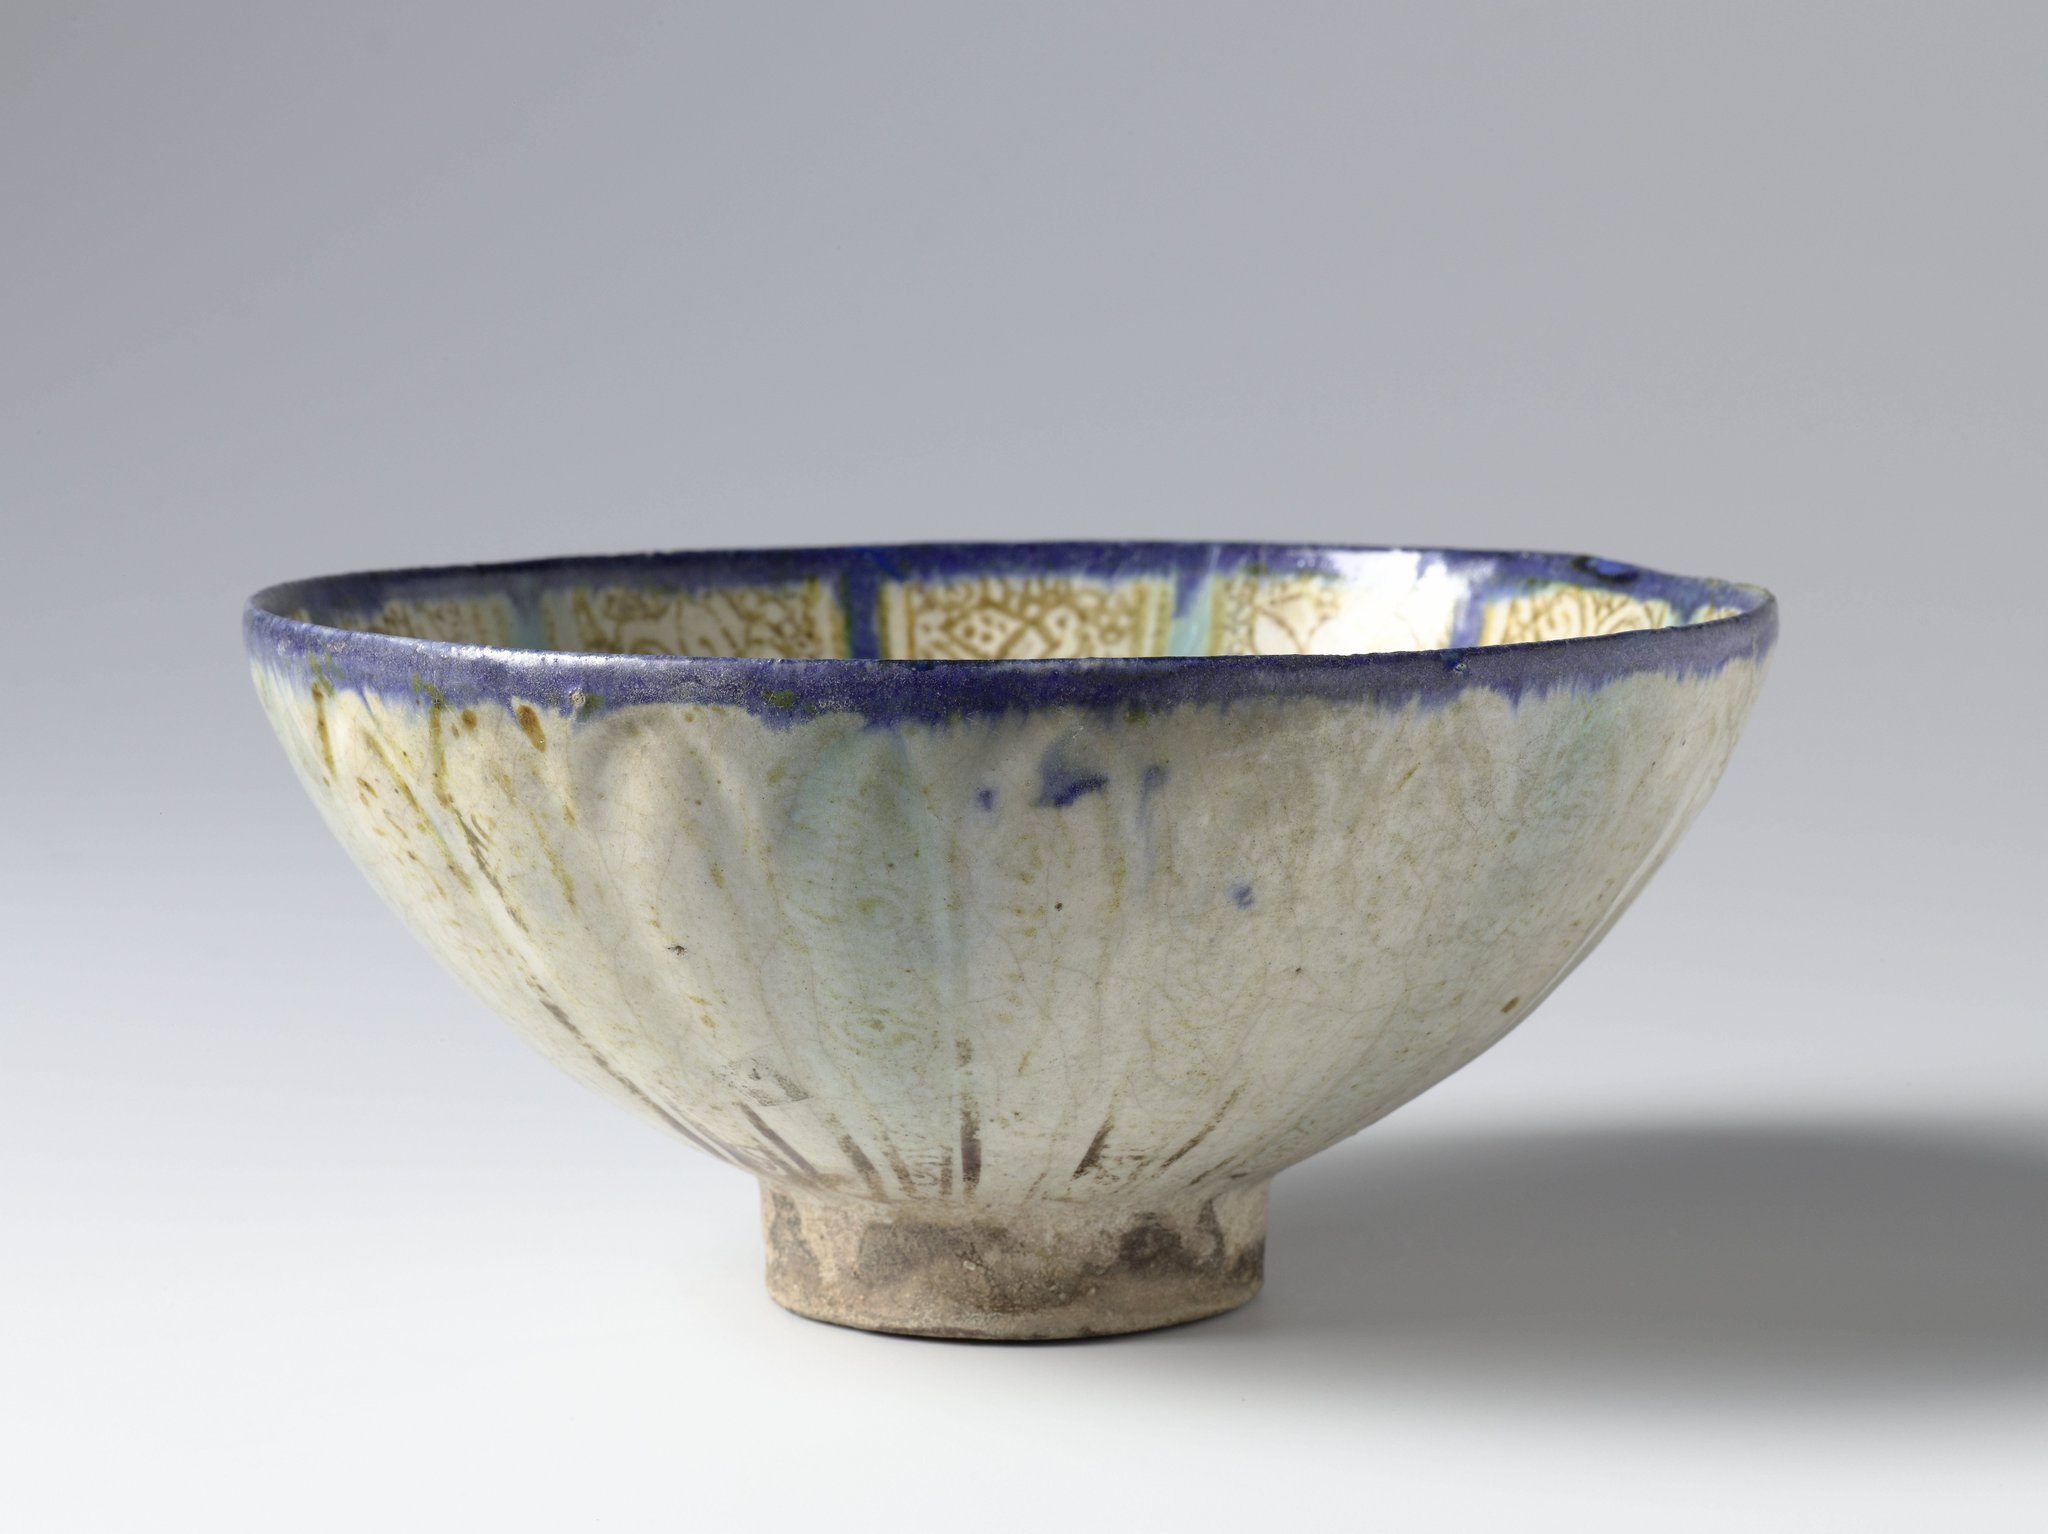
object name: bowl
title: Bowl with twelve panels with floral scrolls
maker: Anonymous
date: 1200-1299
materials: cobalt, earthenware, glaze, luster, paint, quartz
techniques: firing, turning, vitrification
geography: kashan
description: Kom van kwarts-fritgoed met een wit tin-lood-alkaliglazuur waarop radiale lijnen in blauw en kobalt en een decor in luster. De binnenzijde is verdeeld in twaalf vakken met in elk een bloemrank.